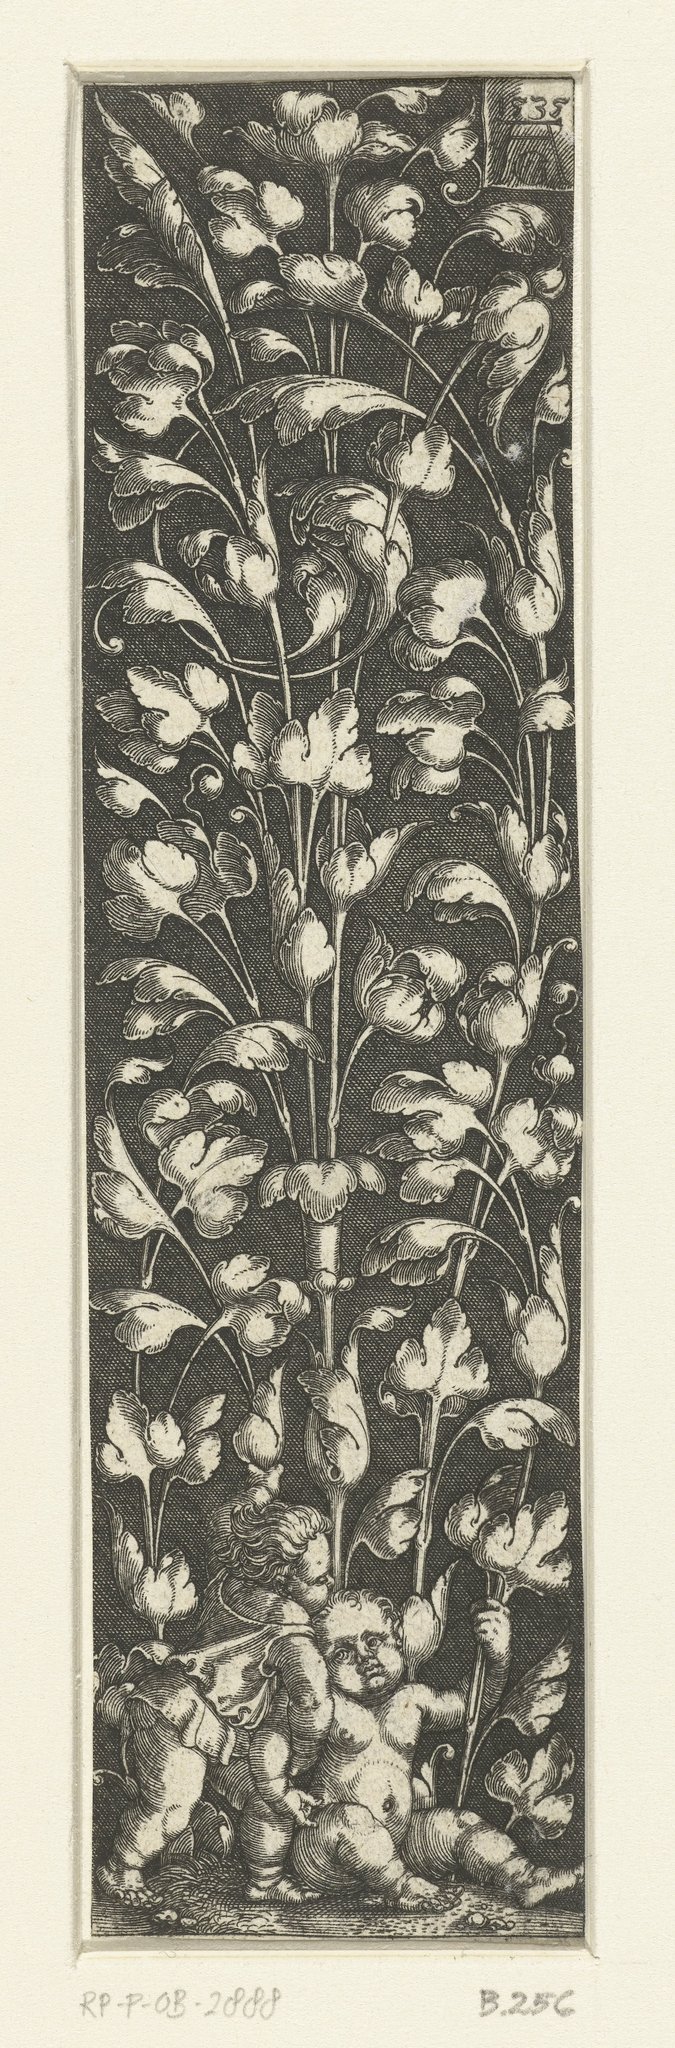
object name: ornament print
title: Bladranken met twee kinderen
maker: heinrich aldegrever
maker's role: draughtsman, print maker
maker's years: 1502-1561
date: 1535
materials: paper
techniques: engraving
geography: germany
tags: child, foliage, tendrils, branches ~ ornament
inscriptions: number: ‘30’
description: Vlakdecoratie met bladranken en een zittend en een staand kind.